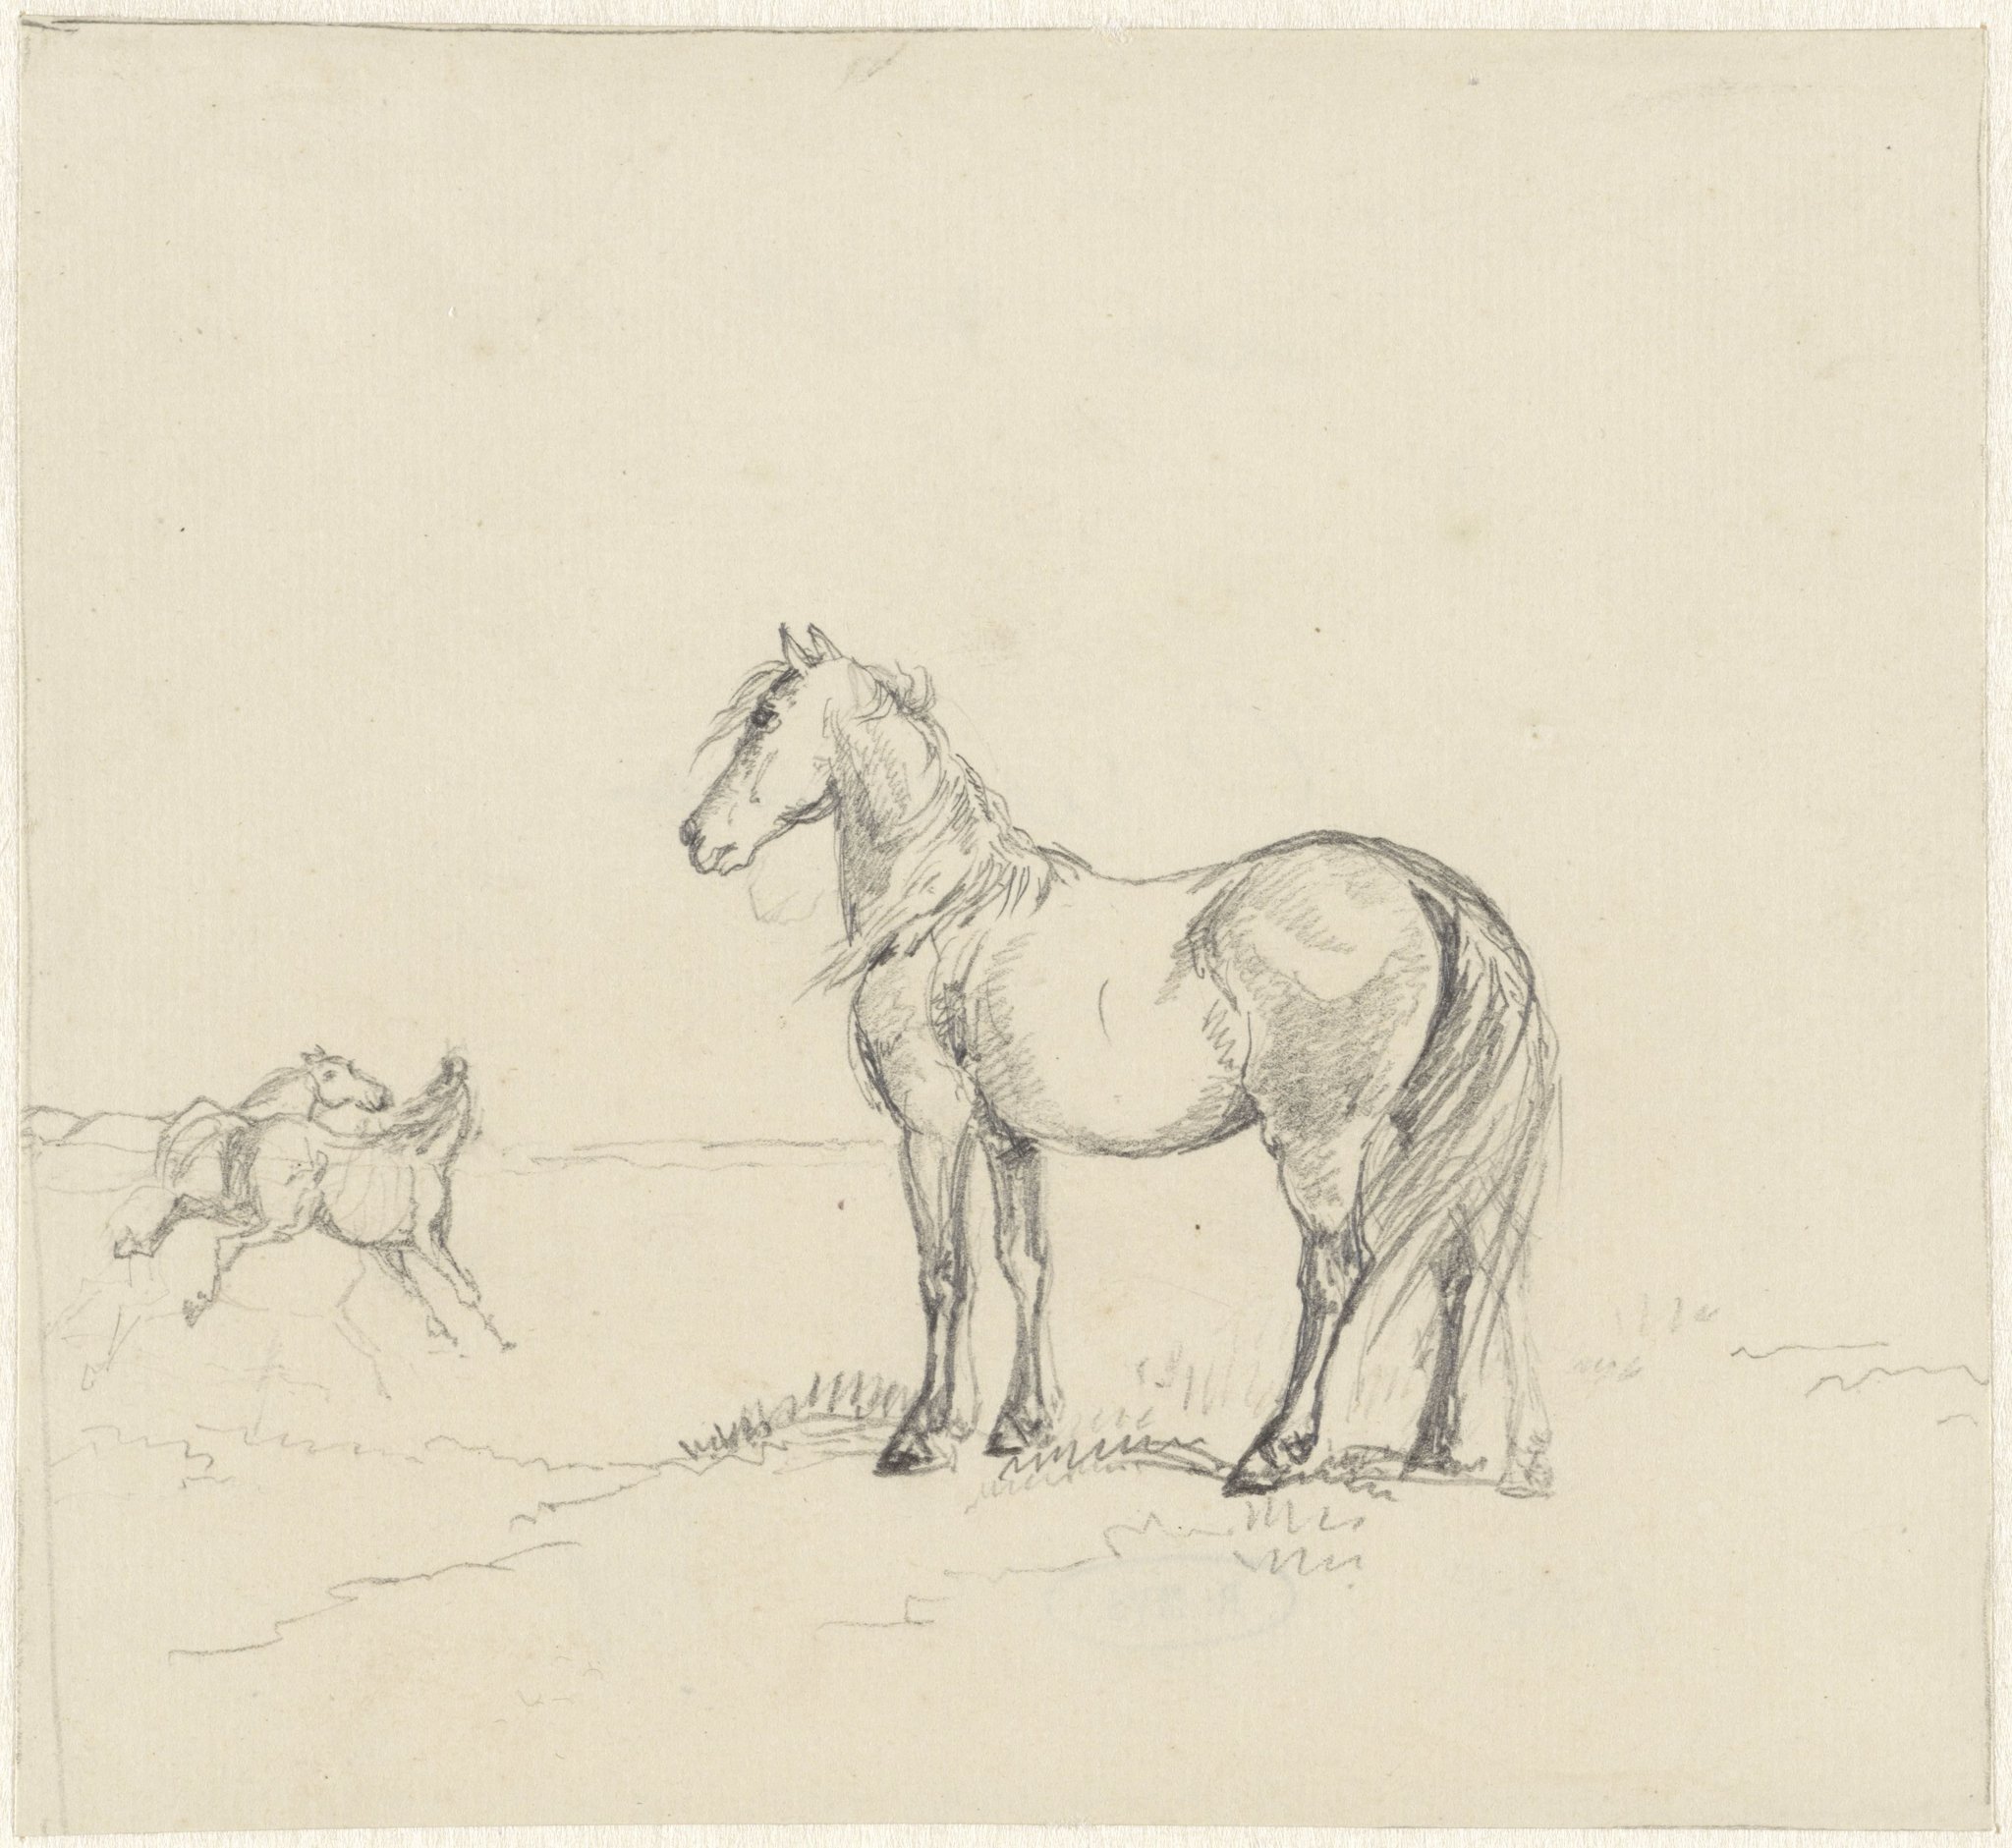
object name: design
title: Drie paarden in een wei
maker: christiaan wilhelmus moorrees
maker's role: draughtsman, print maker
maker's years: 1801-1867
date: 1811-1867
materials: paper, pencil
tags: horse